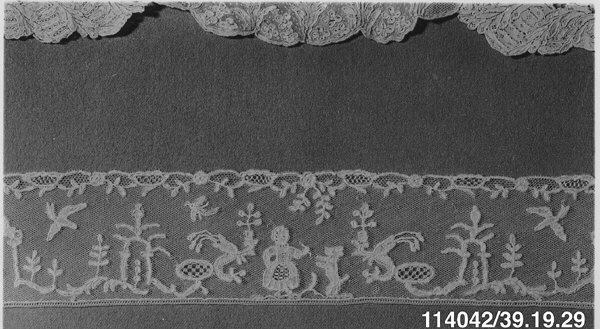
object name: border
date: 1701-1800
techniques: lace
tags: human figures,birds,dogs,leaves